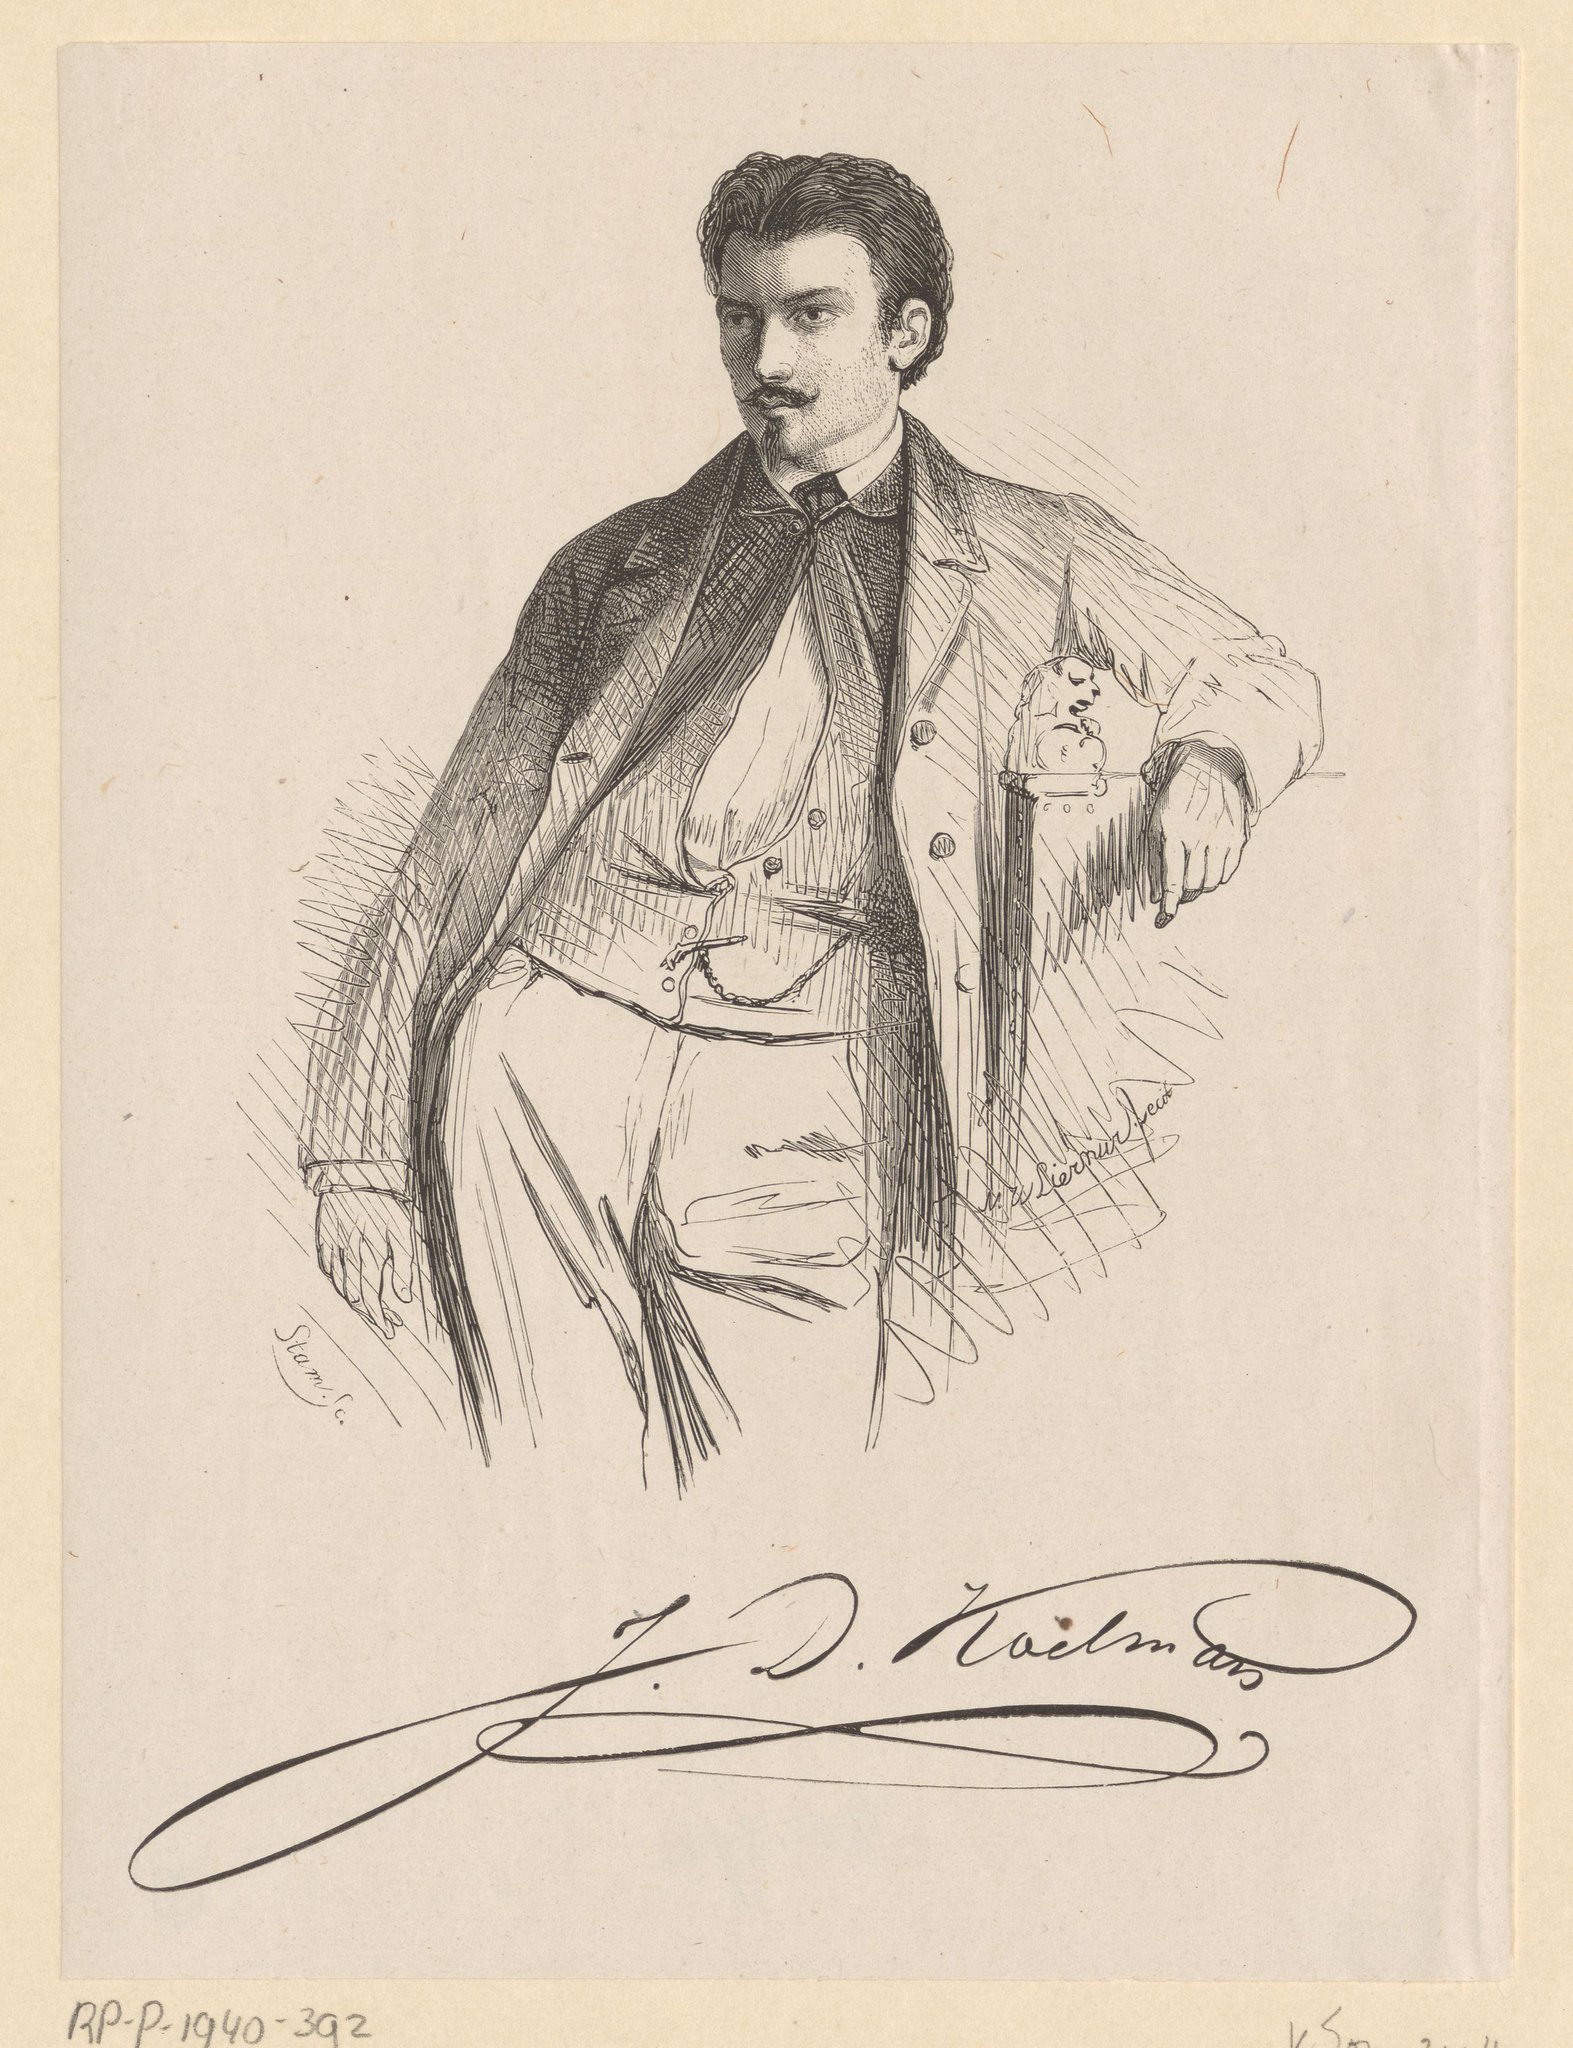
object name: print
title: Portret van Johan Daniël Koelman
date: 1858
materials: paper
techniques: engraving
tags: the hague, print maker, draughtsman, johan daniël koelman, historical persons, portrait, self-portrait of painter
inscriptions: collector's mark: Lugt 2228, collector's mark: Lugt 2760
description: Prent mogelijk uit: Kunstkronijk, 1858. Of uit een eerdere publicatie (1857).